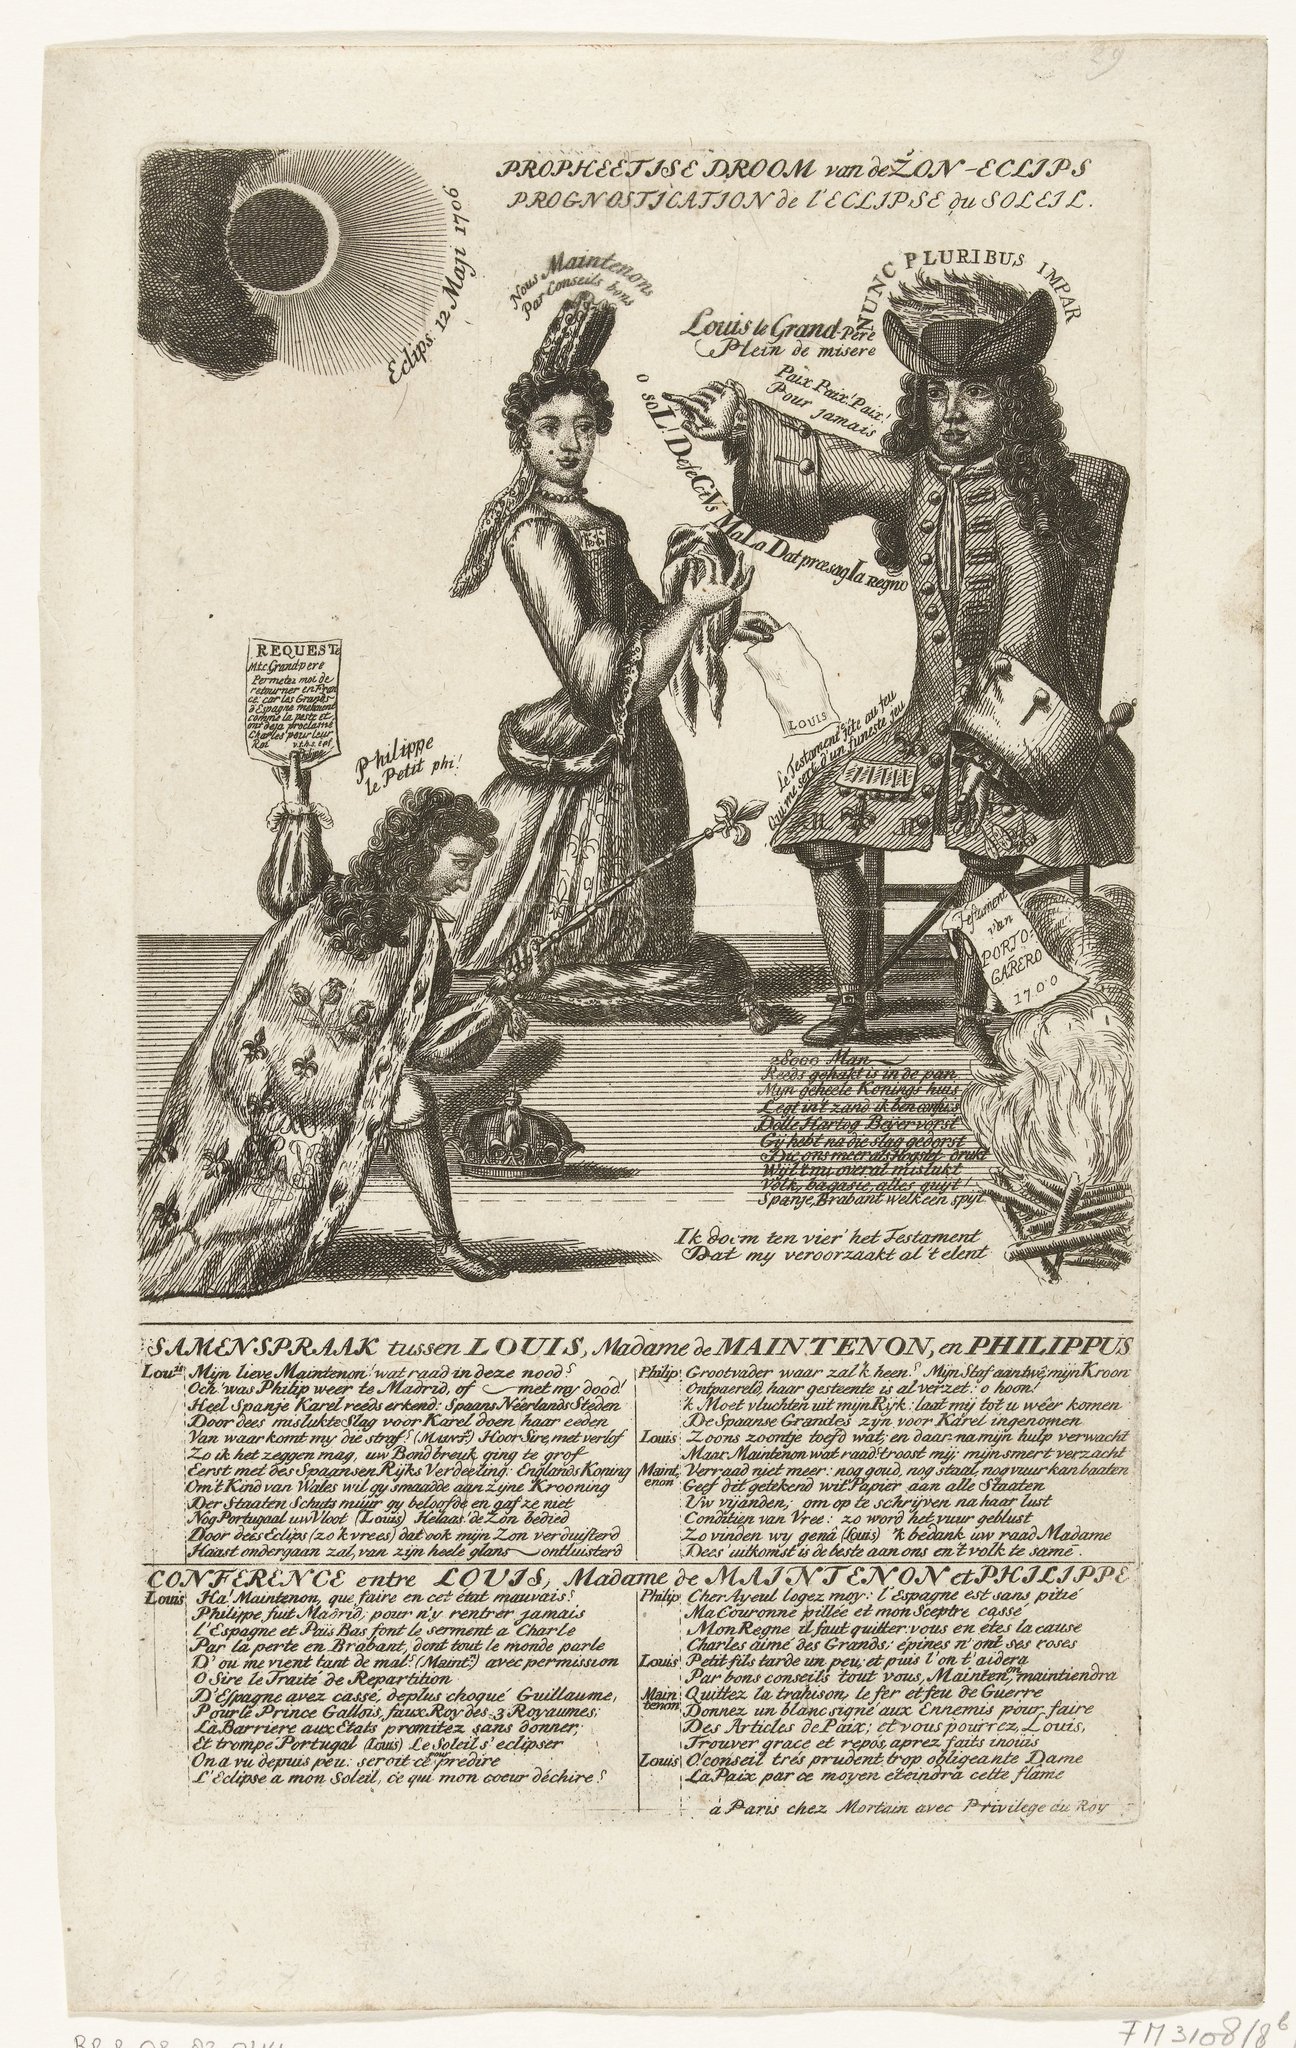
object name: print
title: Madame de Maintenon en Filips V knielen voor Lodewijk XIV, 1706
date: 1706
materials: paper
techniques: etching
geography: amsterdam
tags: lodewijk xiv (koning van frankrijk), madame de maintenon, filips v (koning van spanje), solar eclipse, political caricatures and satires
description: Madame de Maintenon en Filips V overhandigen knielend een verzoek aan Lodewijk XIV. Linksboven de zonsverduistering op 12 mei 1706 tijdens het verlies van Barcelona. In de plaat verzen in het Nederlands en Frans. Spotprent op de situatie in het jaar 1706 in de Spaanse Successieoorlog. Onderdeel van een reeks van 25 spotprenten op de Fransen en bondgenoten uit het jaar 1706.